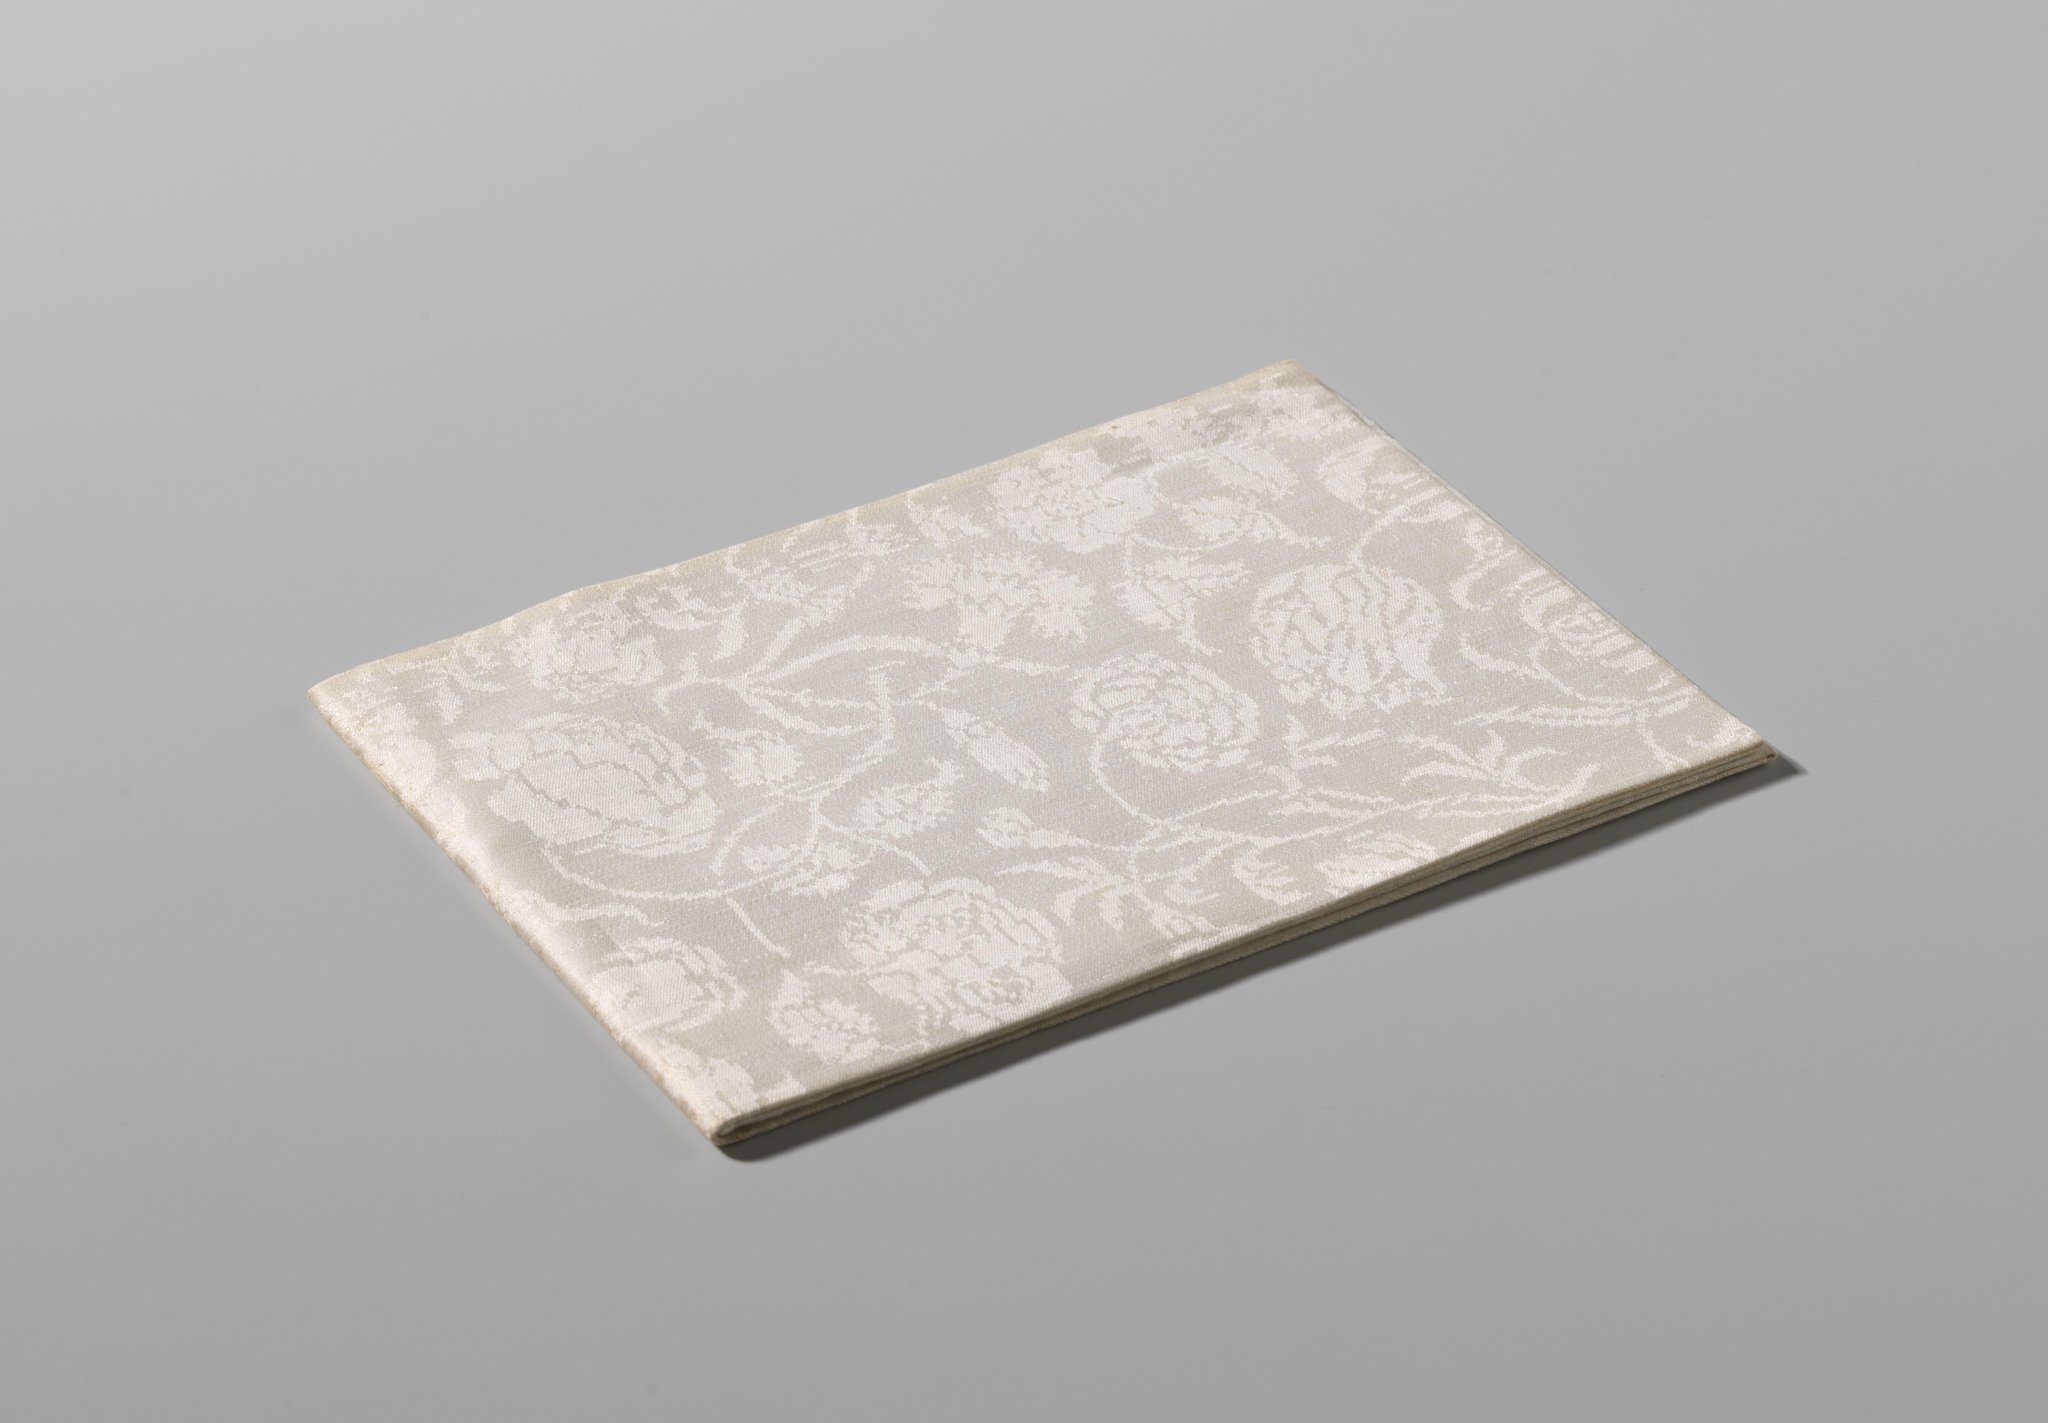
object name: napkin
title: Servet van wit linnendamast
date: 1670-1680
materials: linen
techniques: damask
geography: northern netherlands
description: Wit linnen damasten servet met een patroon van gestrooide bloemen. Merk IG en 12.